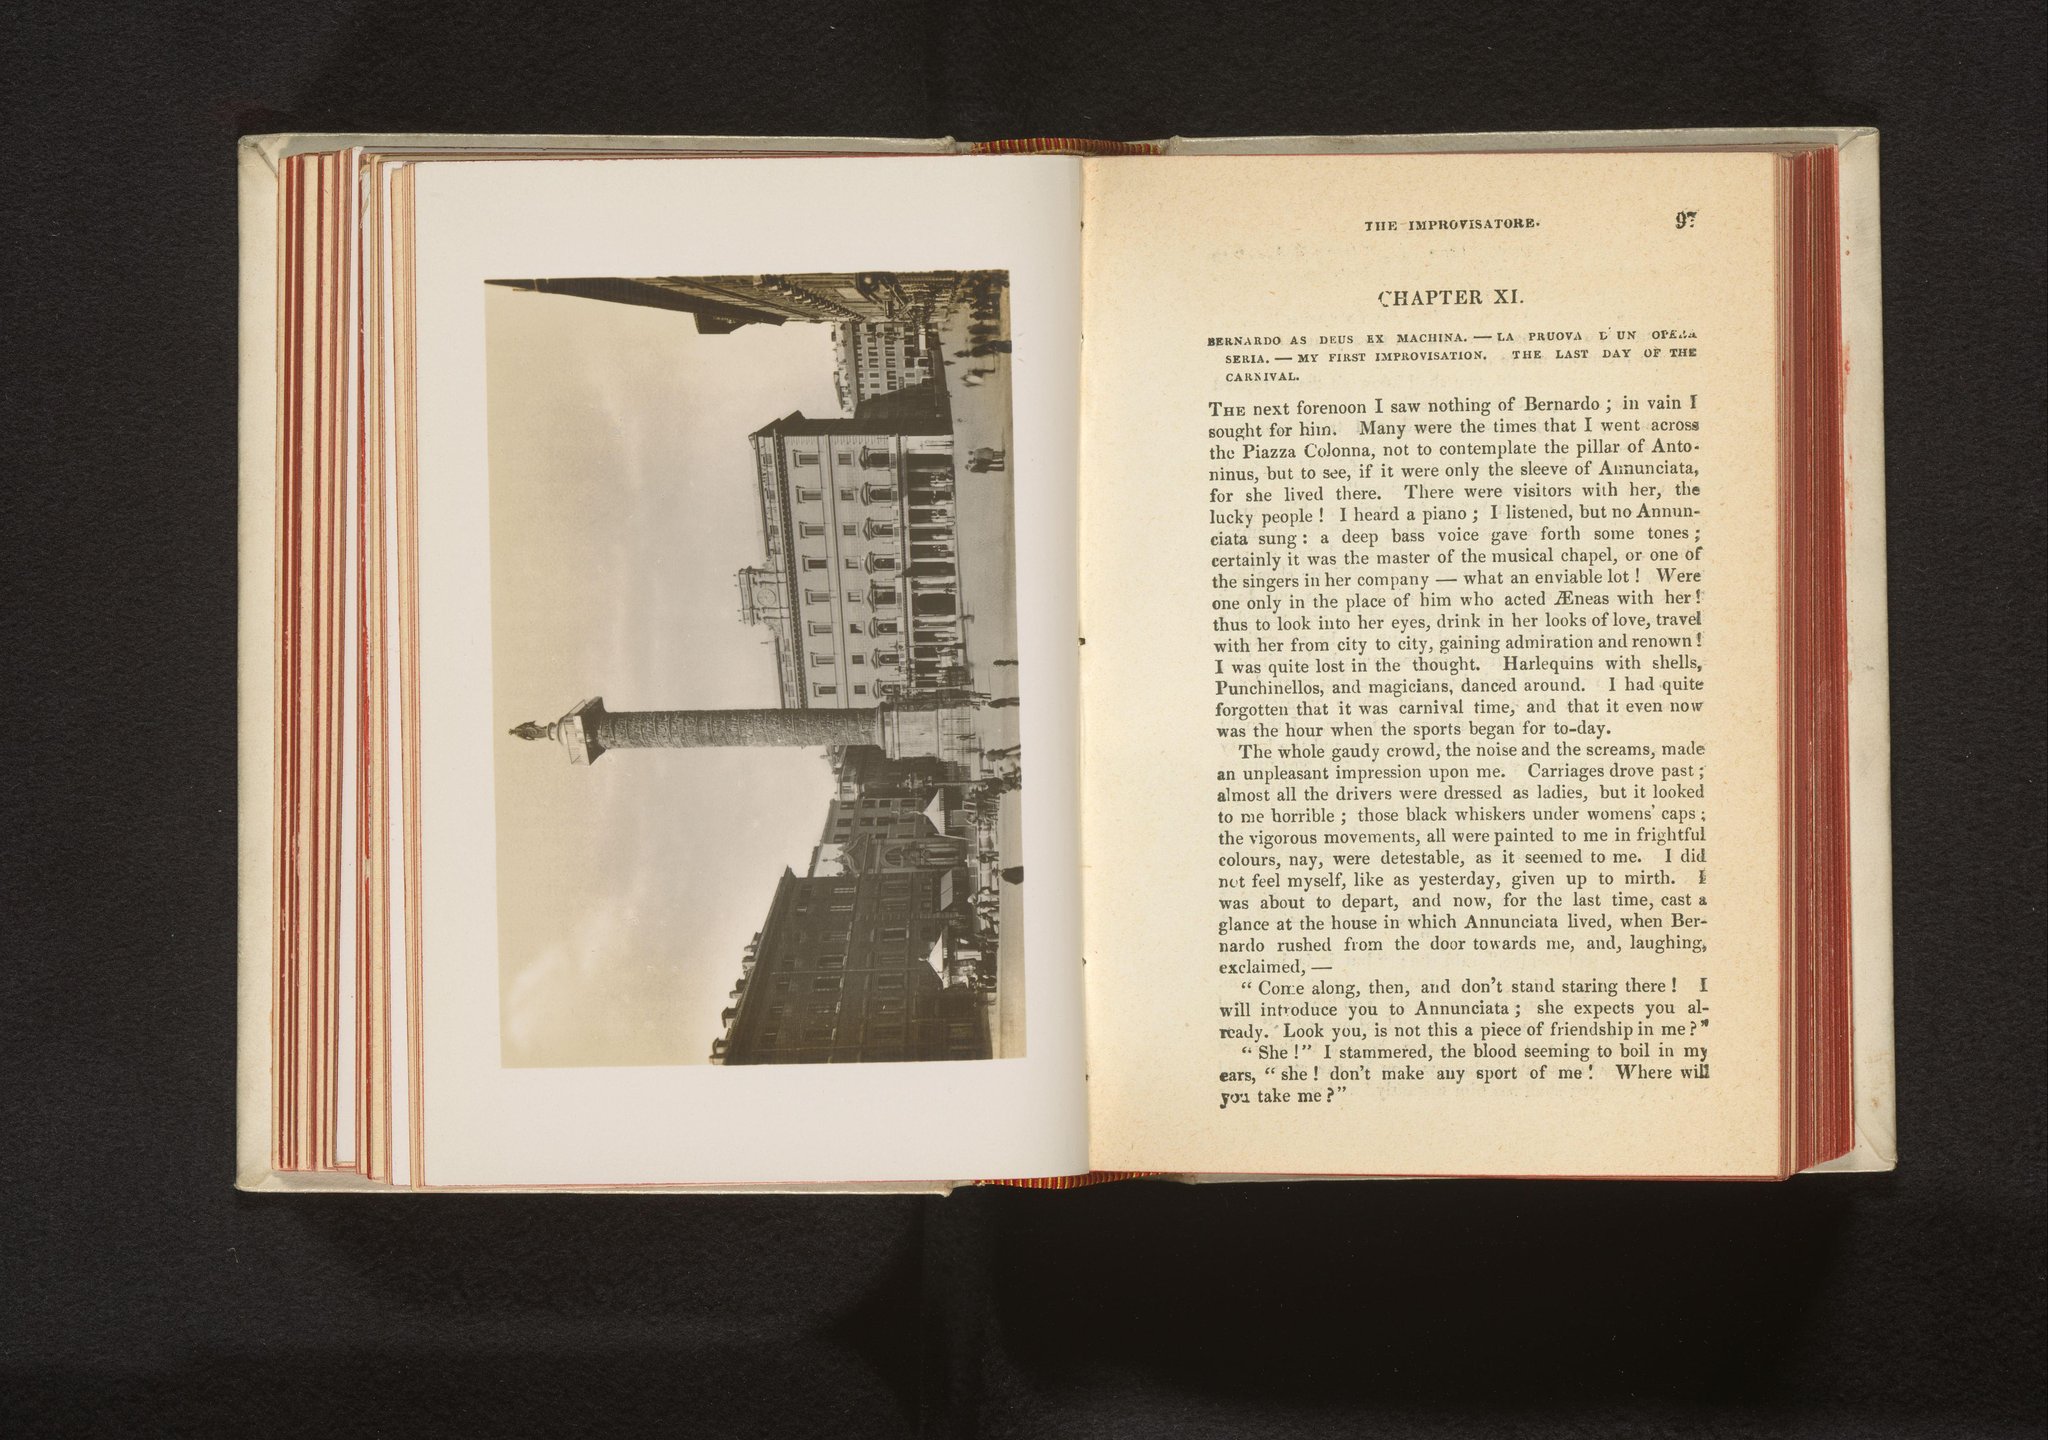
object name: page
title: Zuil van Marcus Aurelius op het Piazza Colonna te Rome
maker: Anonymous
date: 1870-1880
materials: photographic support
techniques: gelatin silver print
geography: piazza colonna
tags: square, place, circus, etc., triumphal column with helical friezes